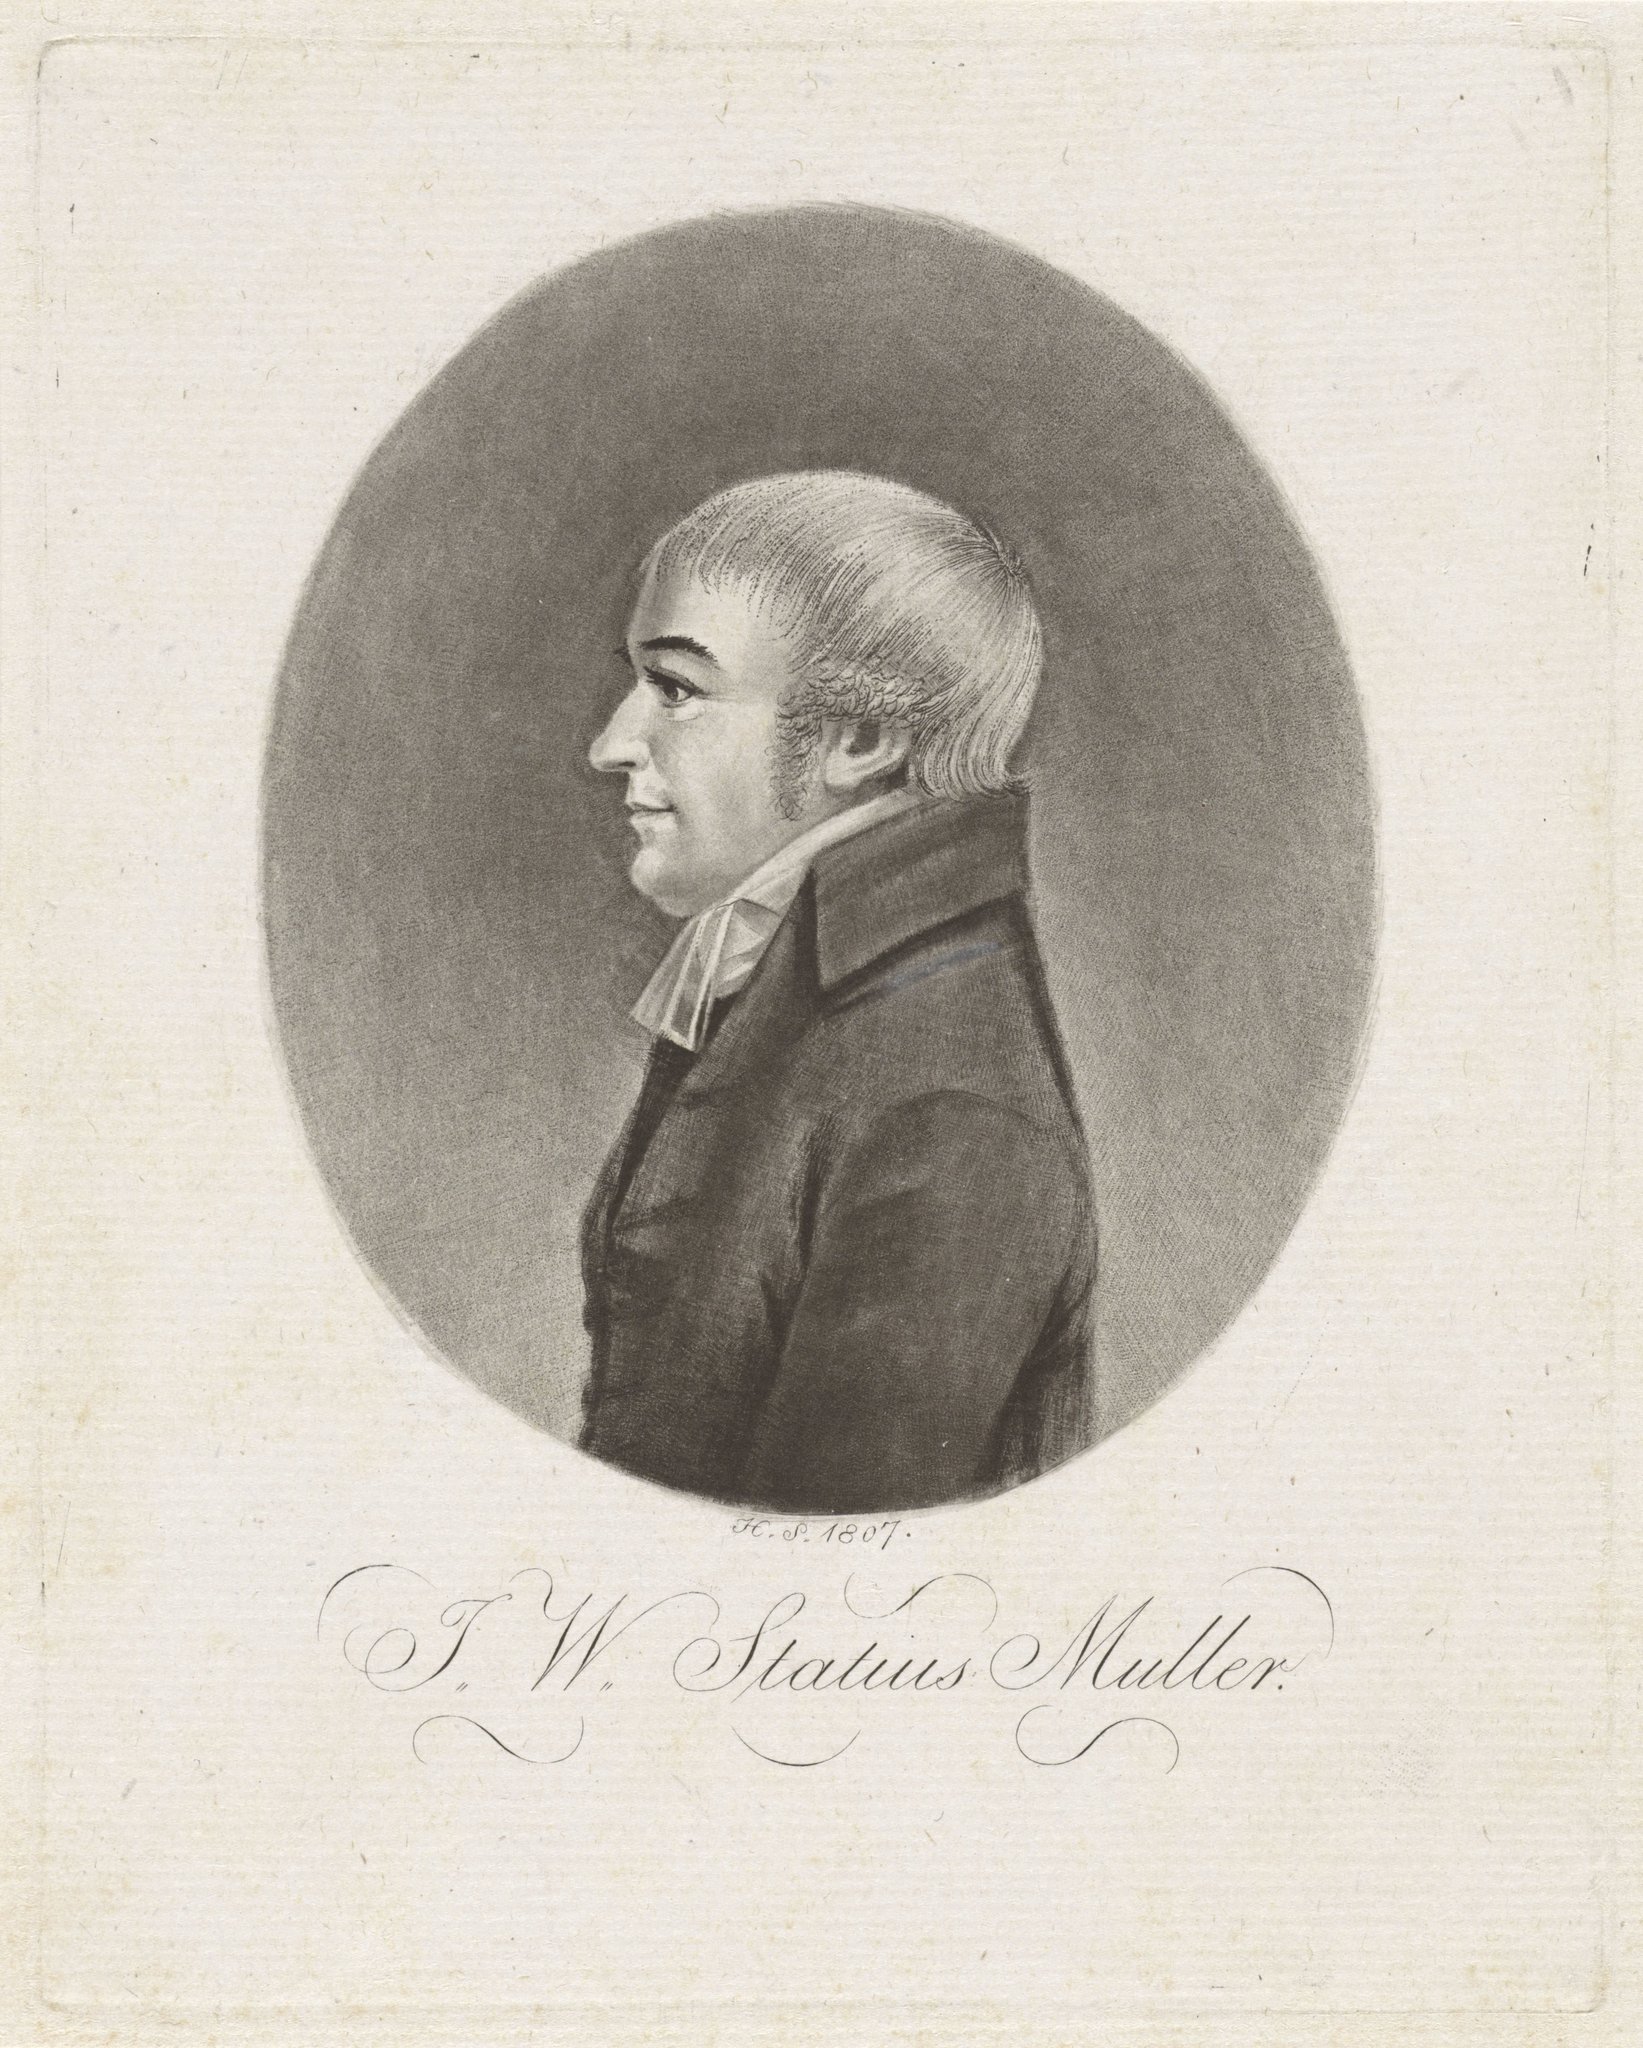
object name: print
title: Portret van de predikant en leraar Johan Wilhelm Statius Muller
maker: hendrik schwegman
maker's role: draughtsman, print maker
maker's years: 1761-1816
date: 1807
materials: paper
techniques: engraving, etching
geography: haarlem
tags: maastricht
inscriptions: collector's mark: Lugt 2228